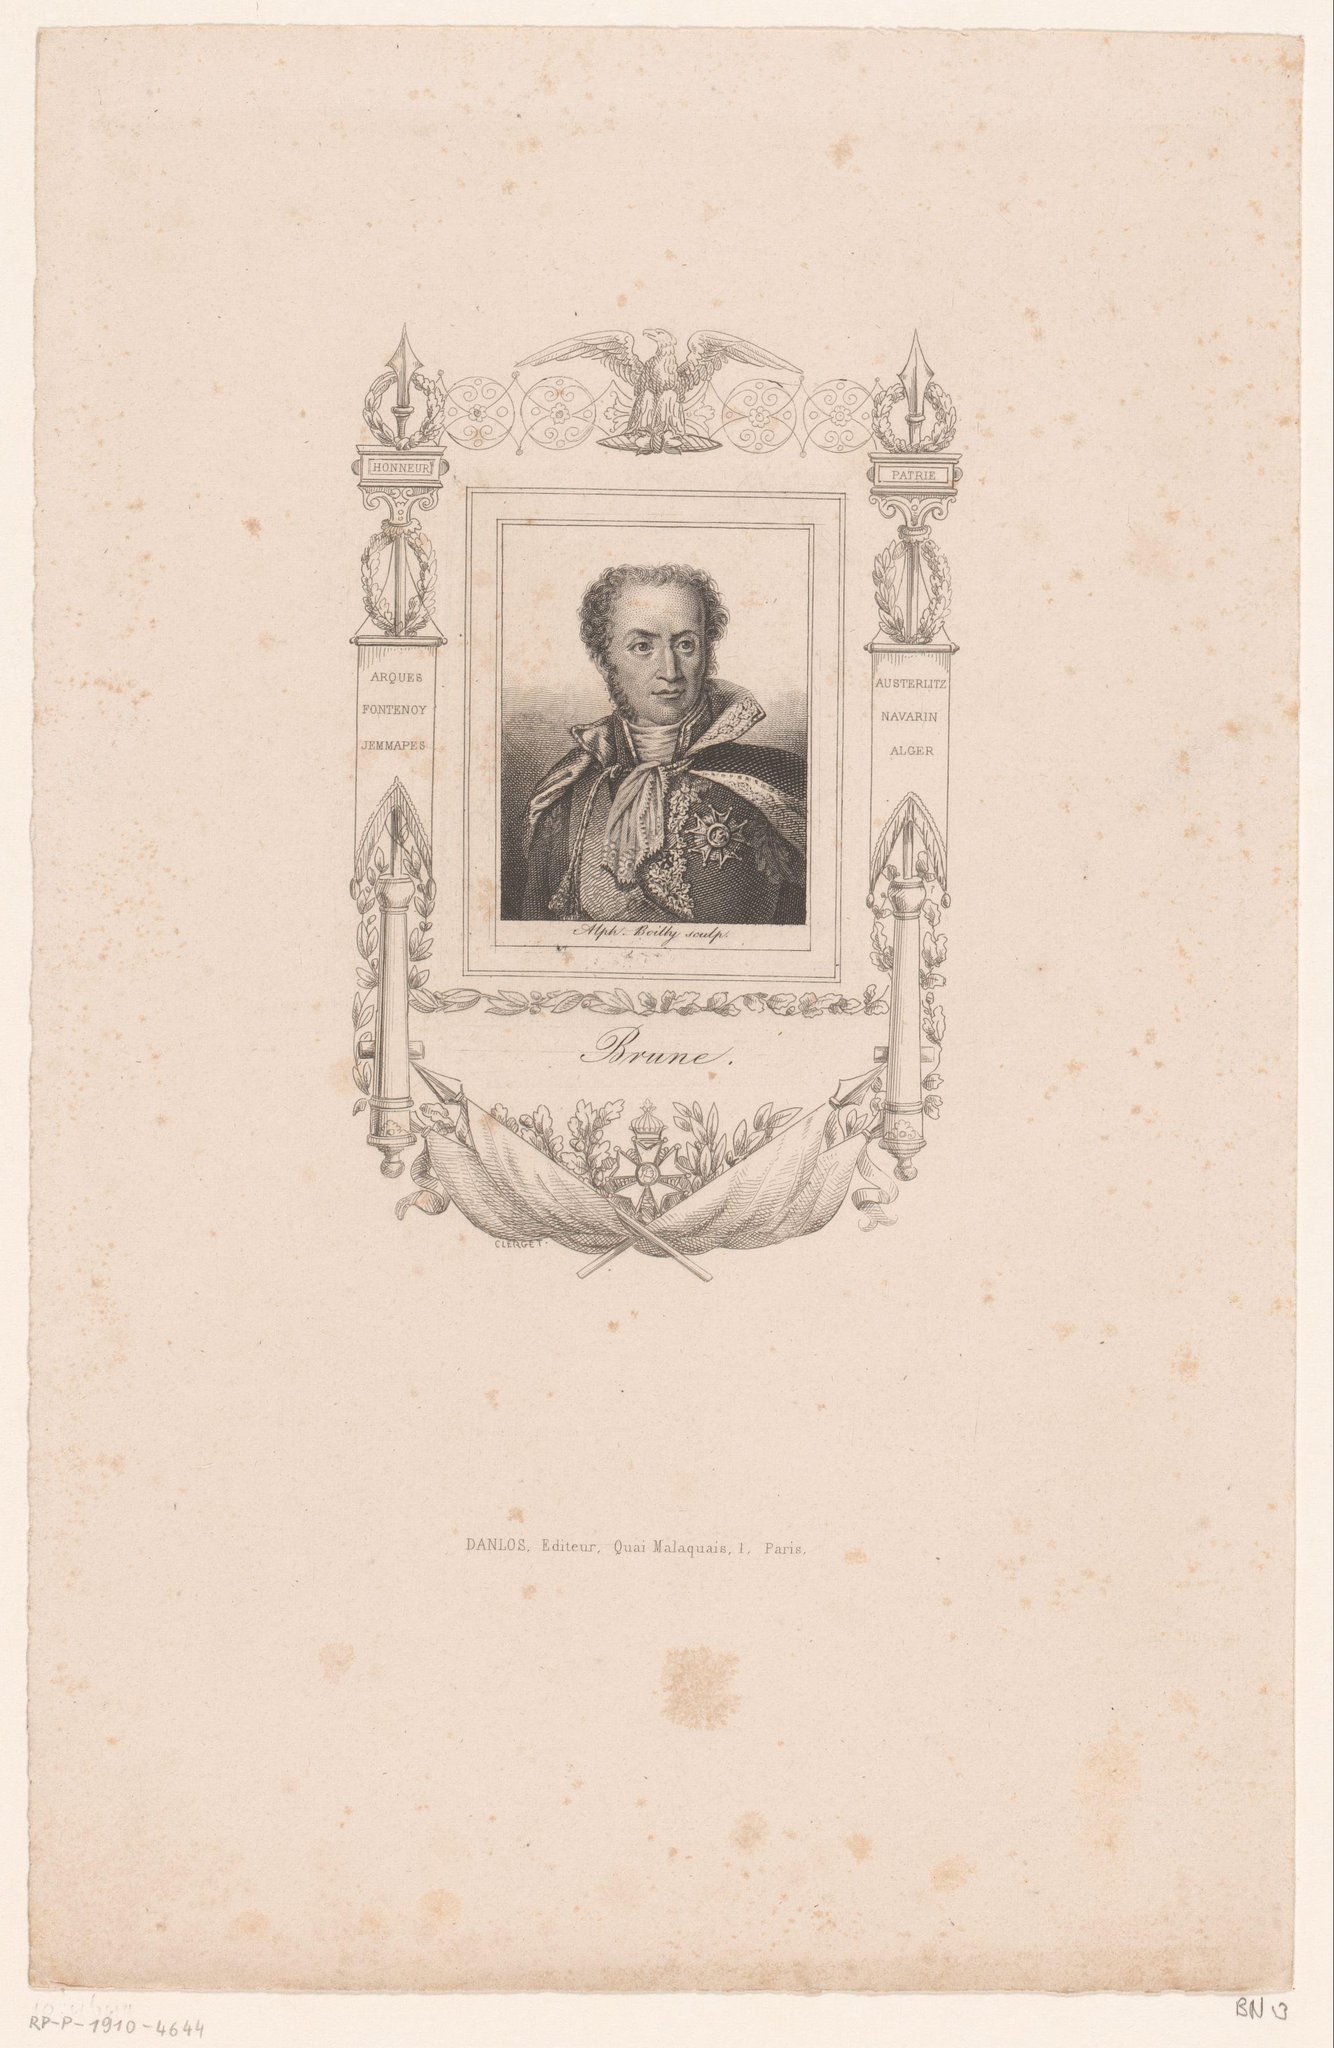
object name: print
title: Brune.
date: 1828-1867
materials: paper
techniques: etching, engraving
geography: france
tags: historical persons, ornament ~ cartouche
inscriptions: collector's mark: Lugt 2228